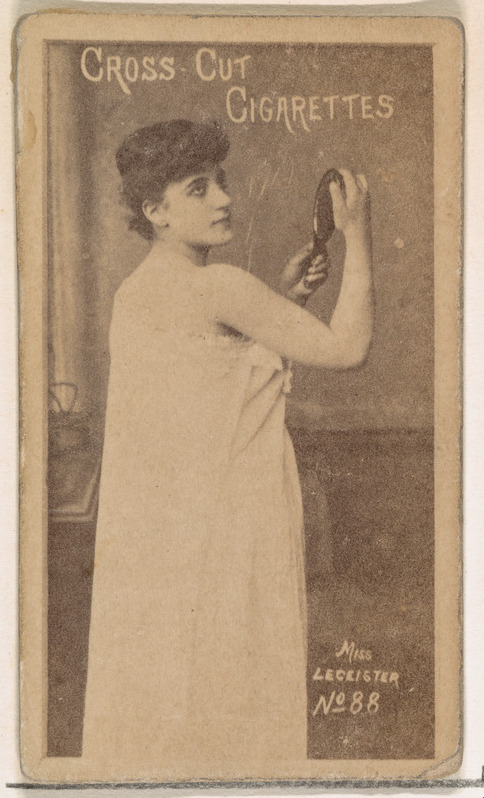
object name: print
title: Card Number 88, Miss Leicester, from the Actors and Actresses series (N145-1) issued by Duke Sons & Co. to promote Cross Cut Cigarettes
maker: w. duke, sons & co.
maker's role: publisher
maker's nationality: american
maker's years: 1870-1920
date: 1880-1889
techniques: albumen silver print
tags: women,actresses